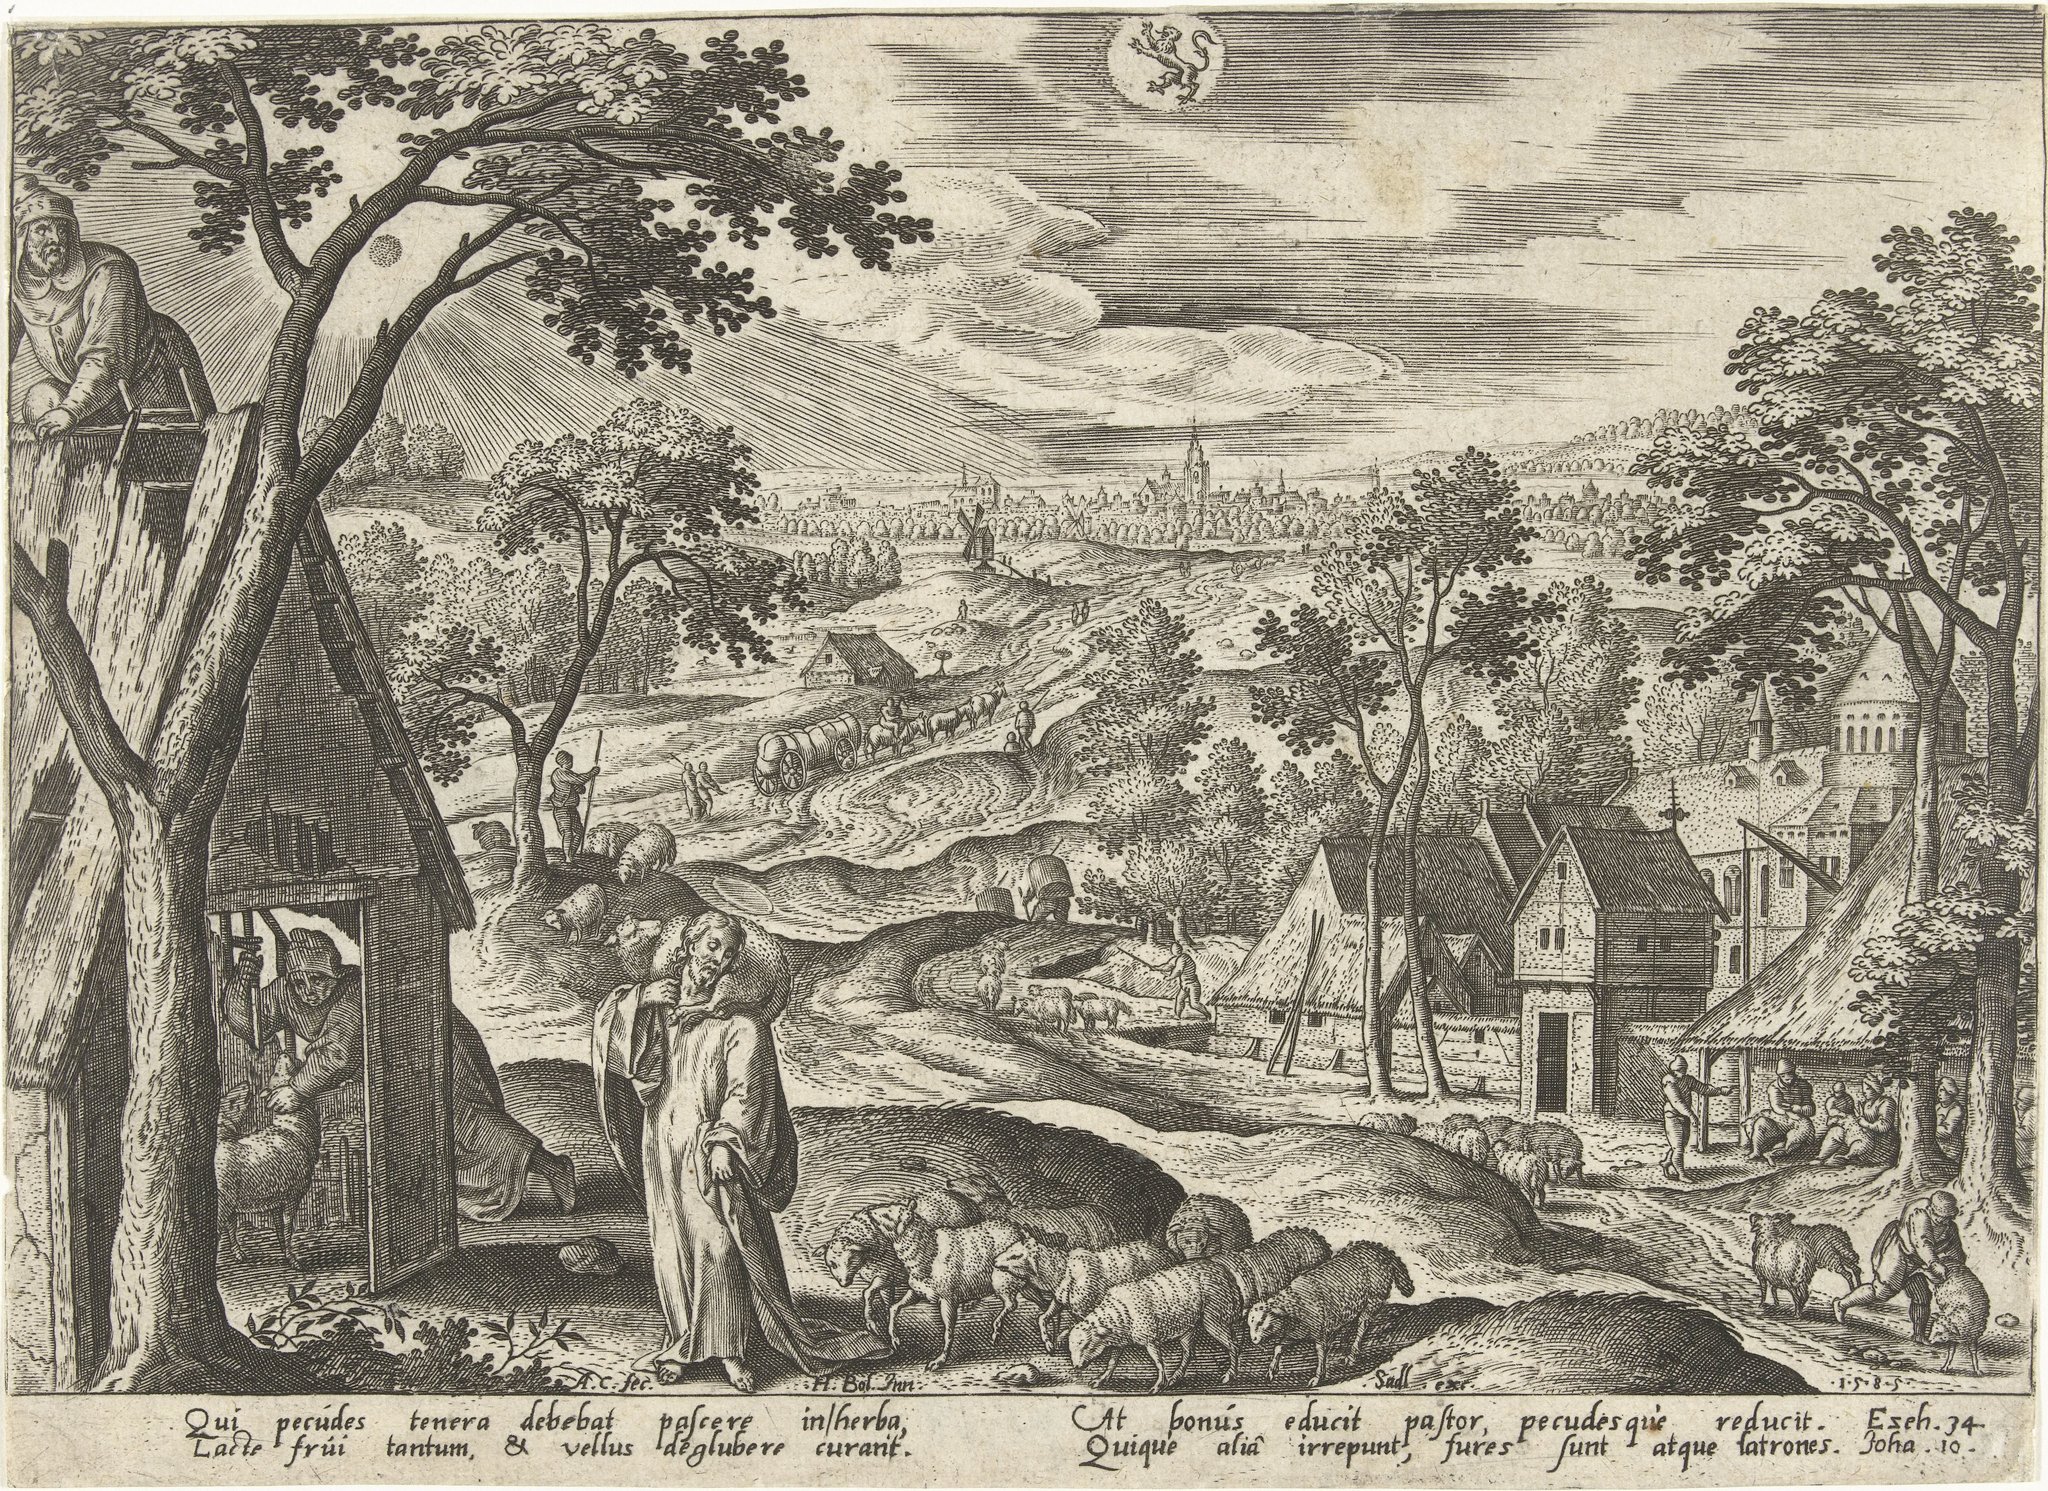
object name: print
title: Juli: de Goede Herder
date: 1585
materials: paper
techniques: engraving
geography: antwerp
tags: christ as good shepherd, landscape symbolizing july (+ with leo (july))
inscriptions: collector's mark: Lugt 2228, collector's mark: Lugt 2760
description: Een zomerlandschap. In de lucht het astrologisch teken van juli: Leeuw. Centraal Christus als de Goede Herder die liefdevol met zijn schapen omgaat (Joh. 10). De prent heeft een Latijns onderschrift en is deel van een serie over het leven van Christus uitgebeeld in de twaalf maanden van het jaar.